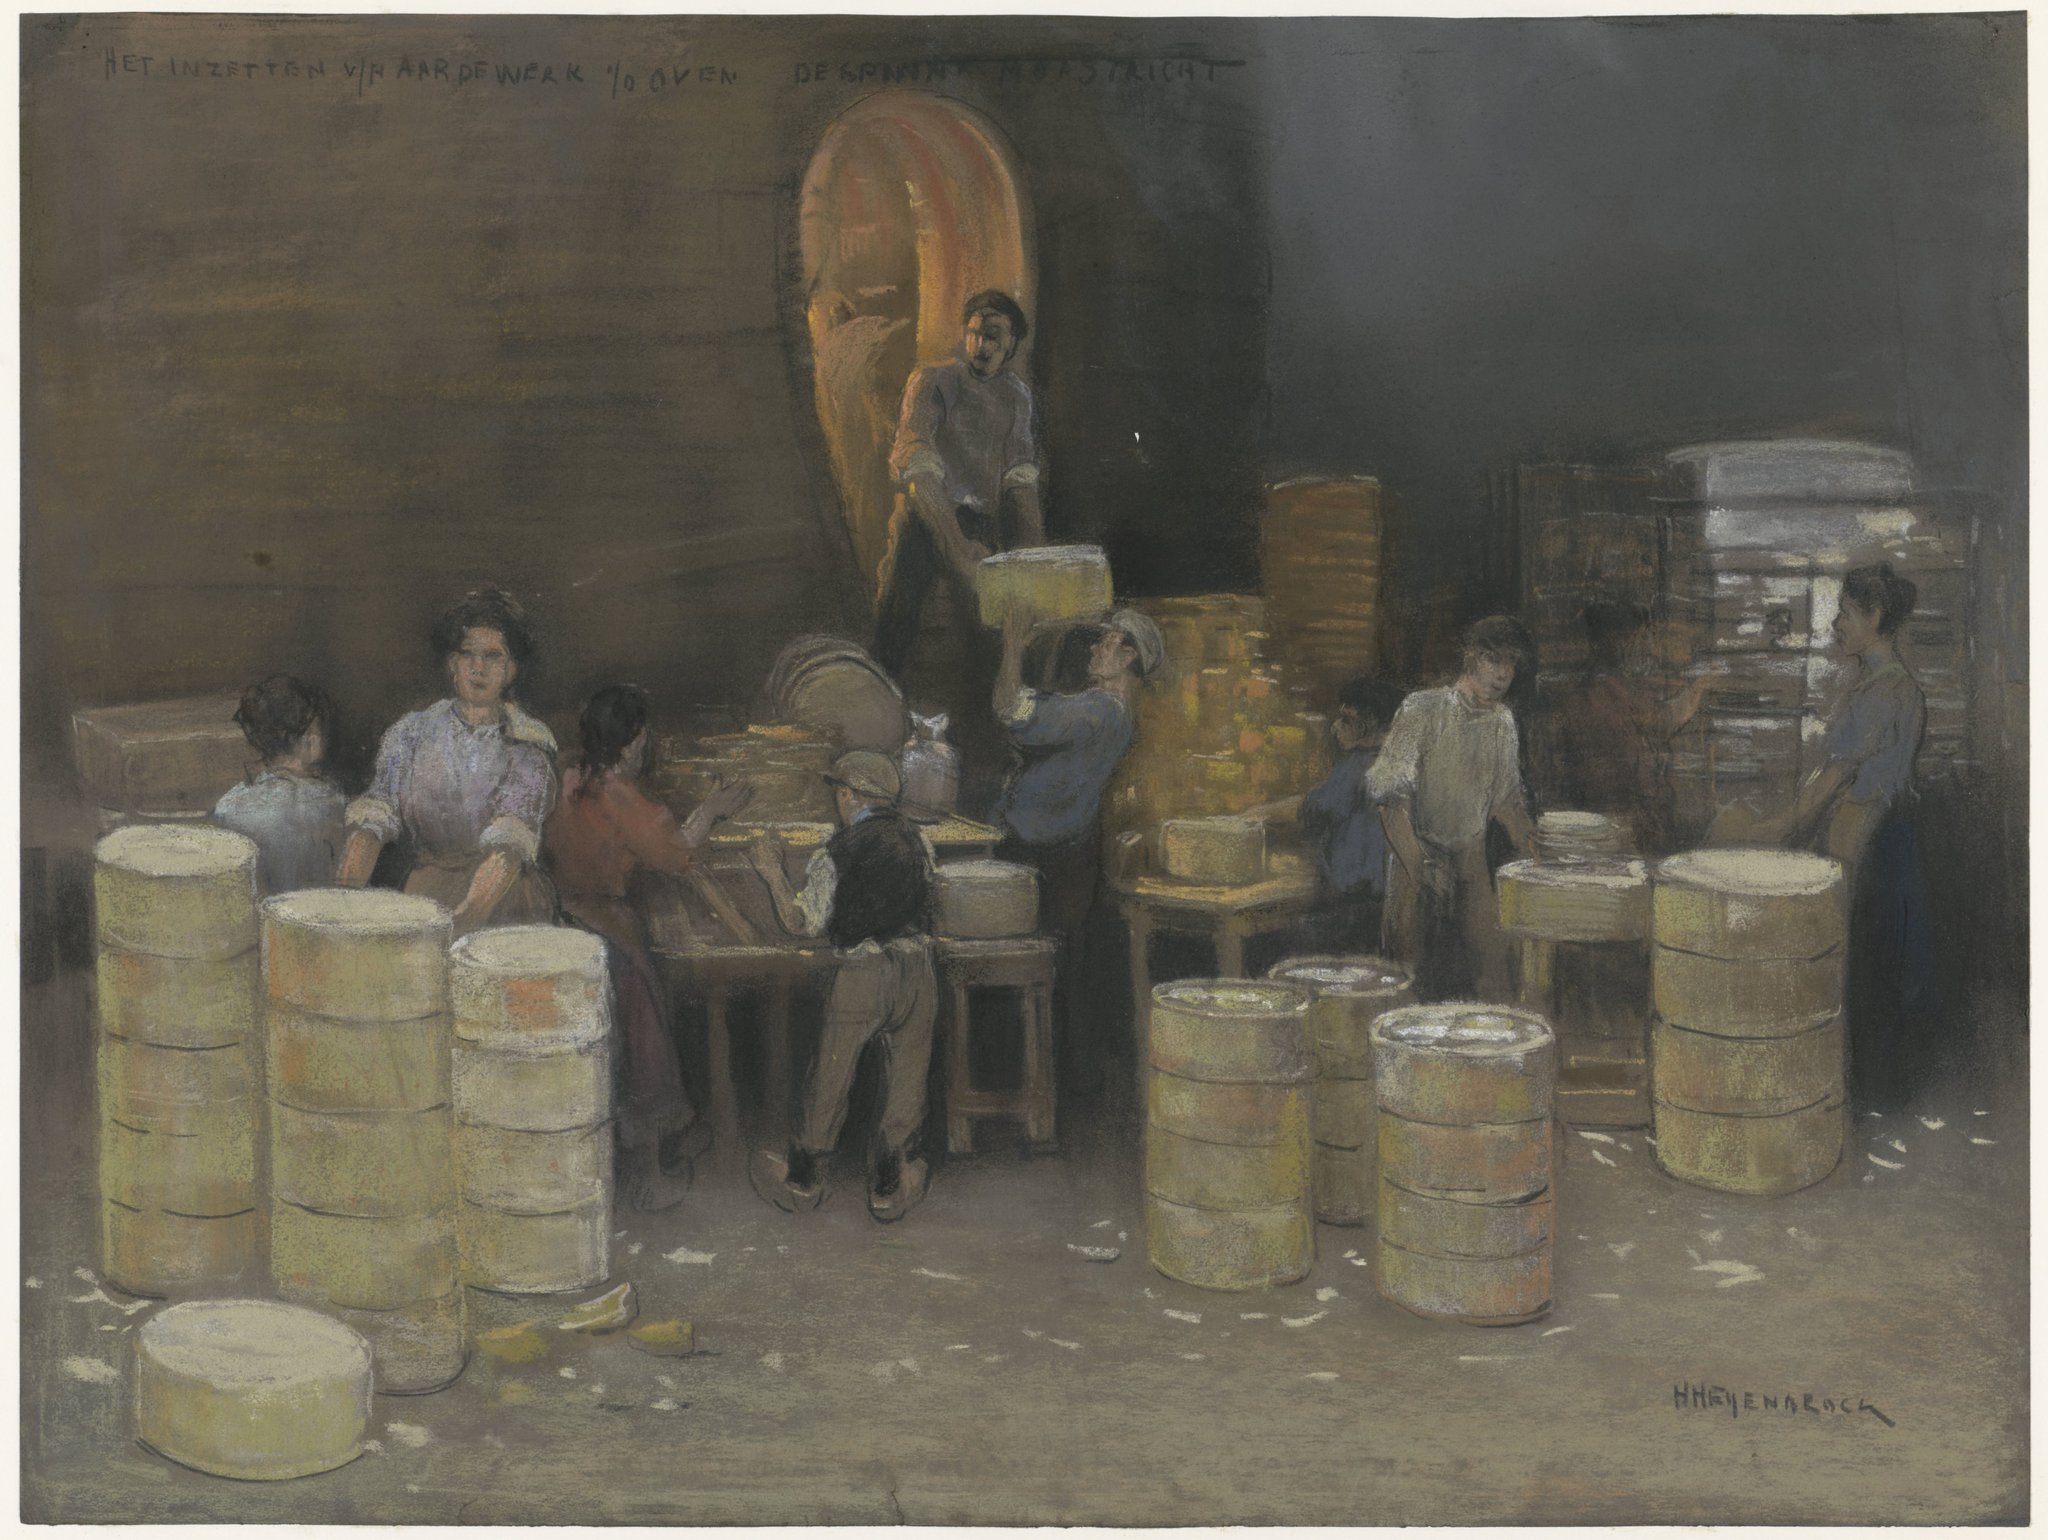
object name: drawing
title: Het inzetten van het aardewerk in de oven van De Sphinx te Maastricht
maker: herman heijenbrock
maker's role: draughtsman, painter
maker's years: 1871-1948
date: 1881-1948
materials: paper, pastel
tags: ceramics industry, names of organizations, companies, trade unions, etc., fire, oven, furnace ~ interior of industrial structure, maastricht